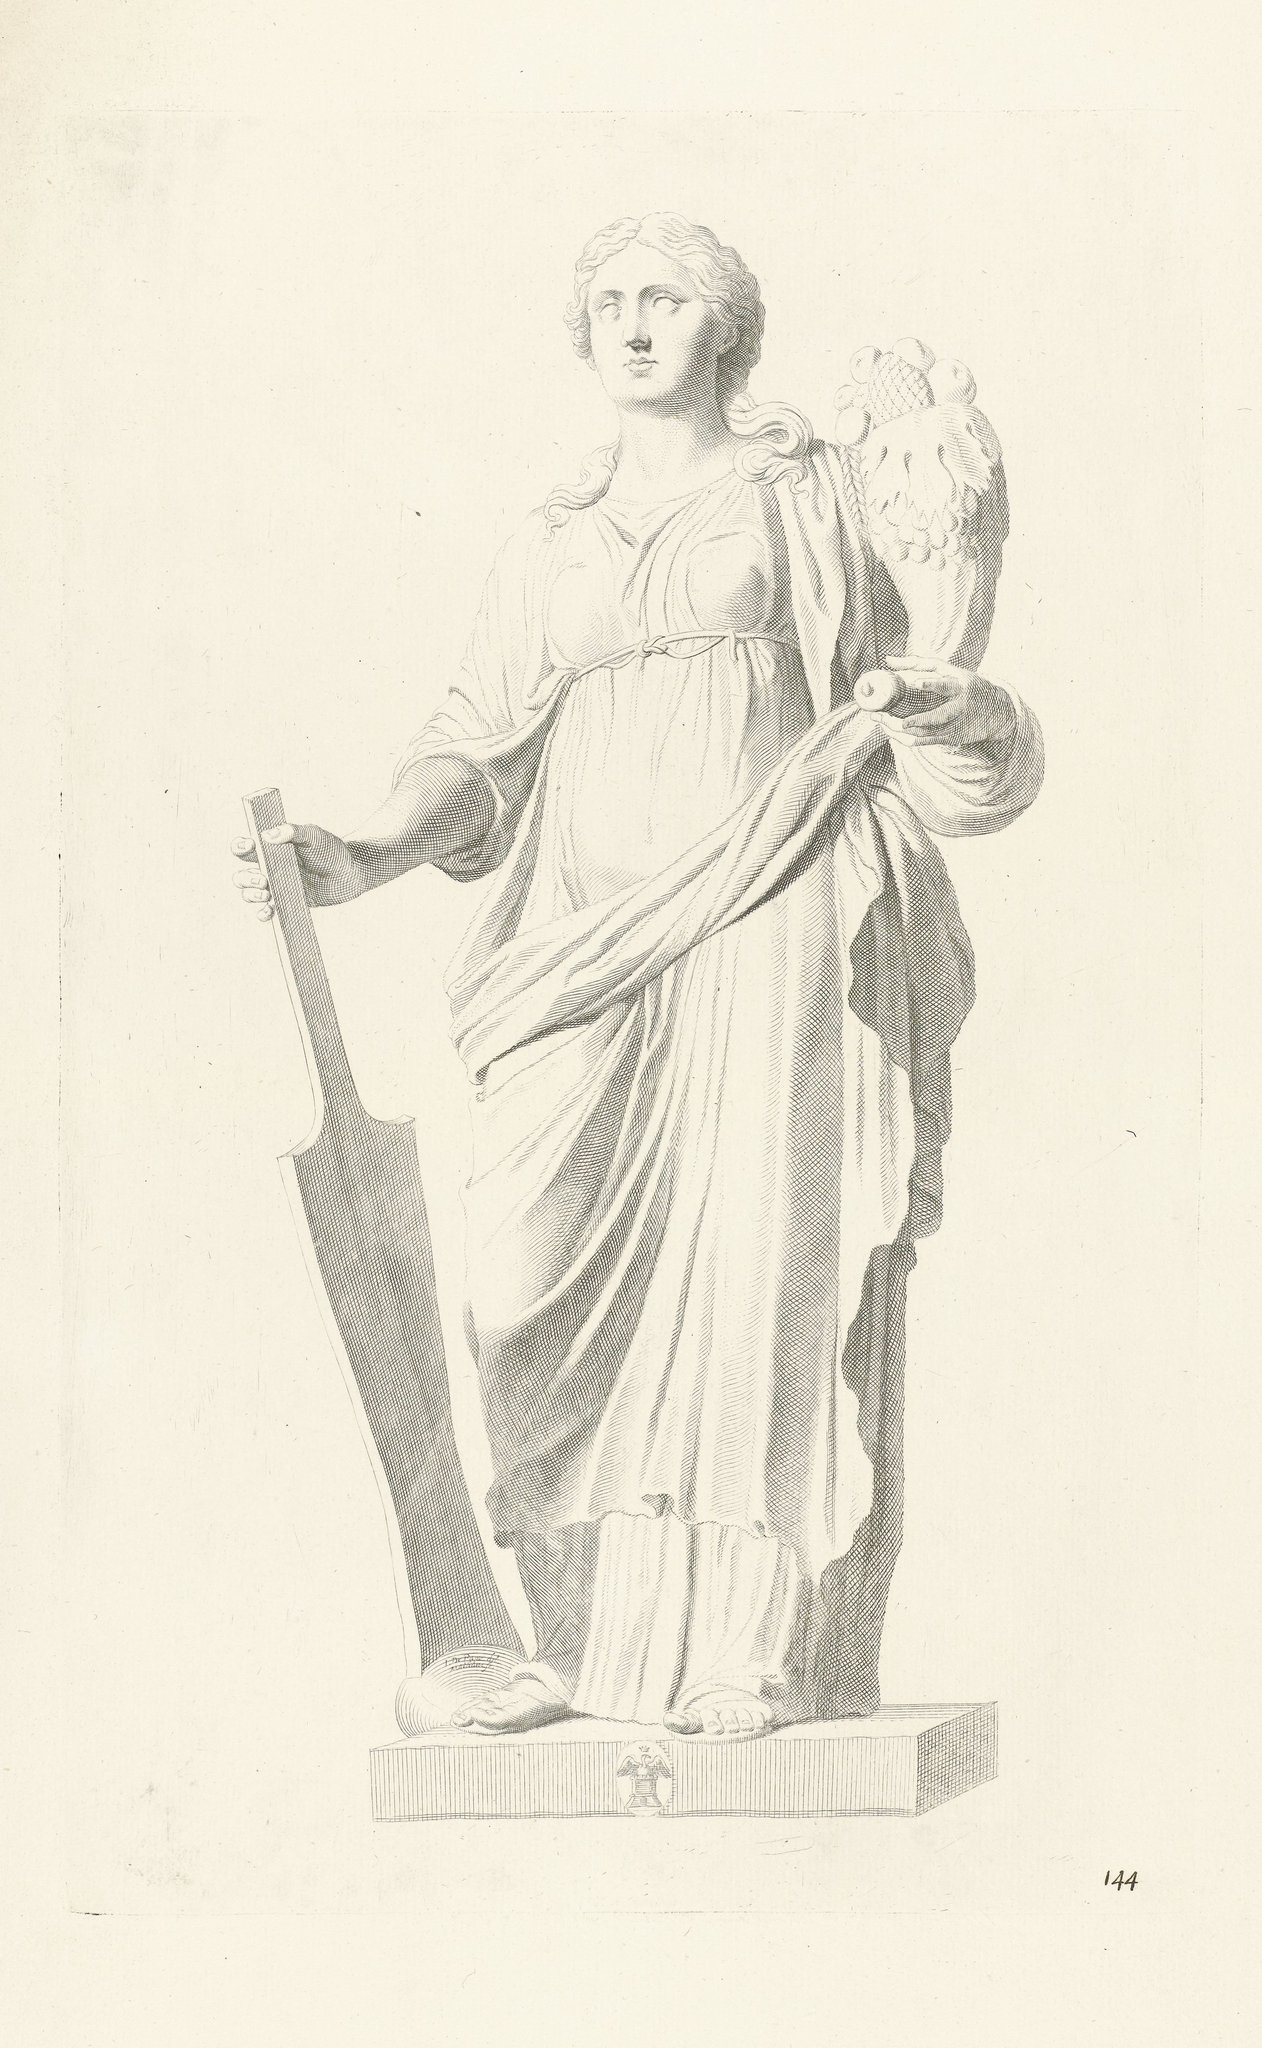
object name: print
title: Standbeeld van Fortuna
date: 1640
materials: paper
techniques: engraving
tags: rome, vincenzo giustiniani (1564-1637), 'cornucopia', horn of plenty, fortuna as roman personification, piece of sculpture, reproduction of a piece of sculpture, parts of ship's exterior: rudder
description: Standbeeld van een vrouw met een roer en een Hoorn des Overvloeds (Fortuna). Op de voet het wapenschild van Vincenzo Giustiniani. Prent uit een publicatie met reproductieprenten naar de sculpturen in de verzameling in de Galleria Giustiniani te Rome.